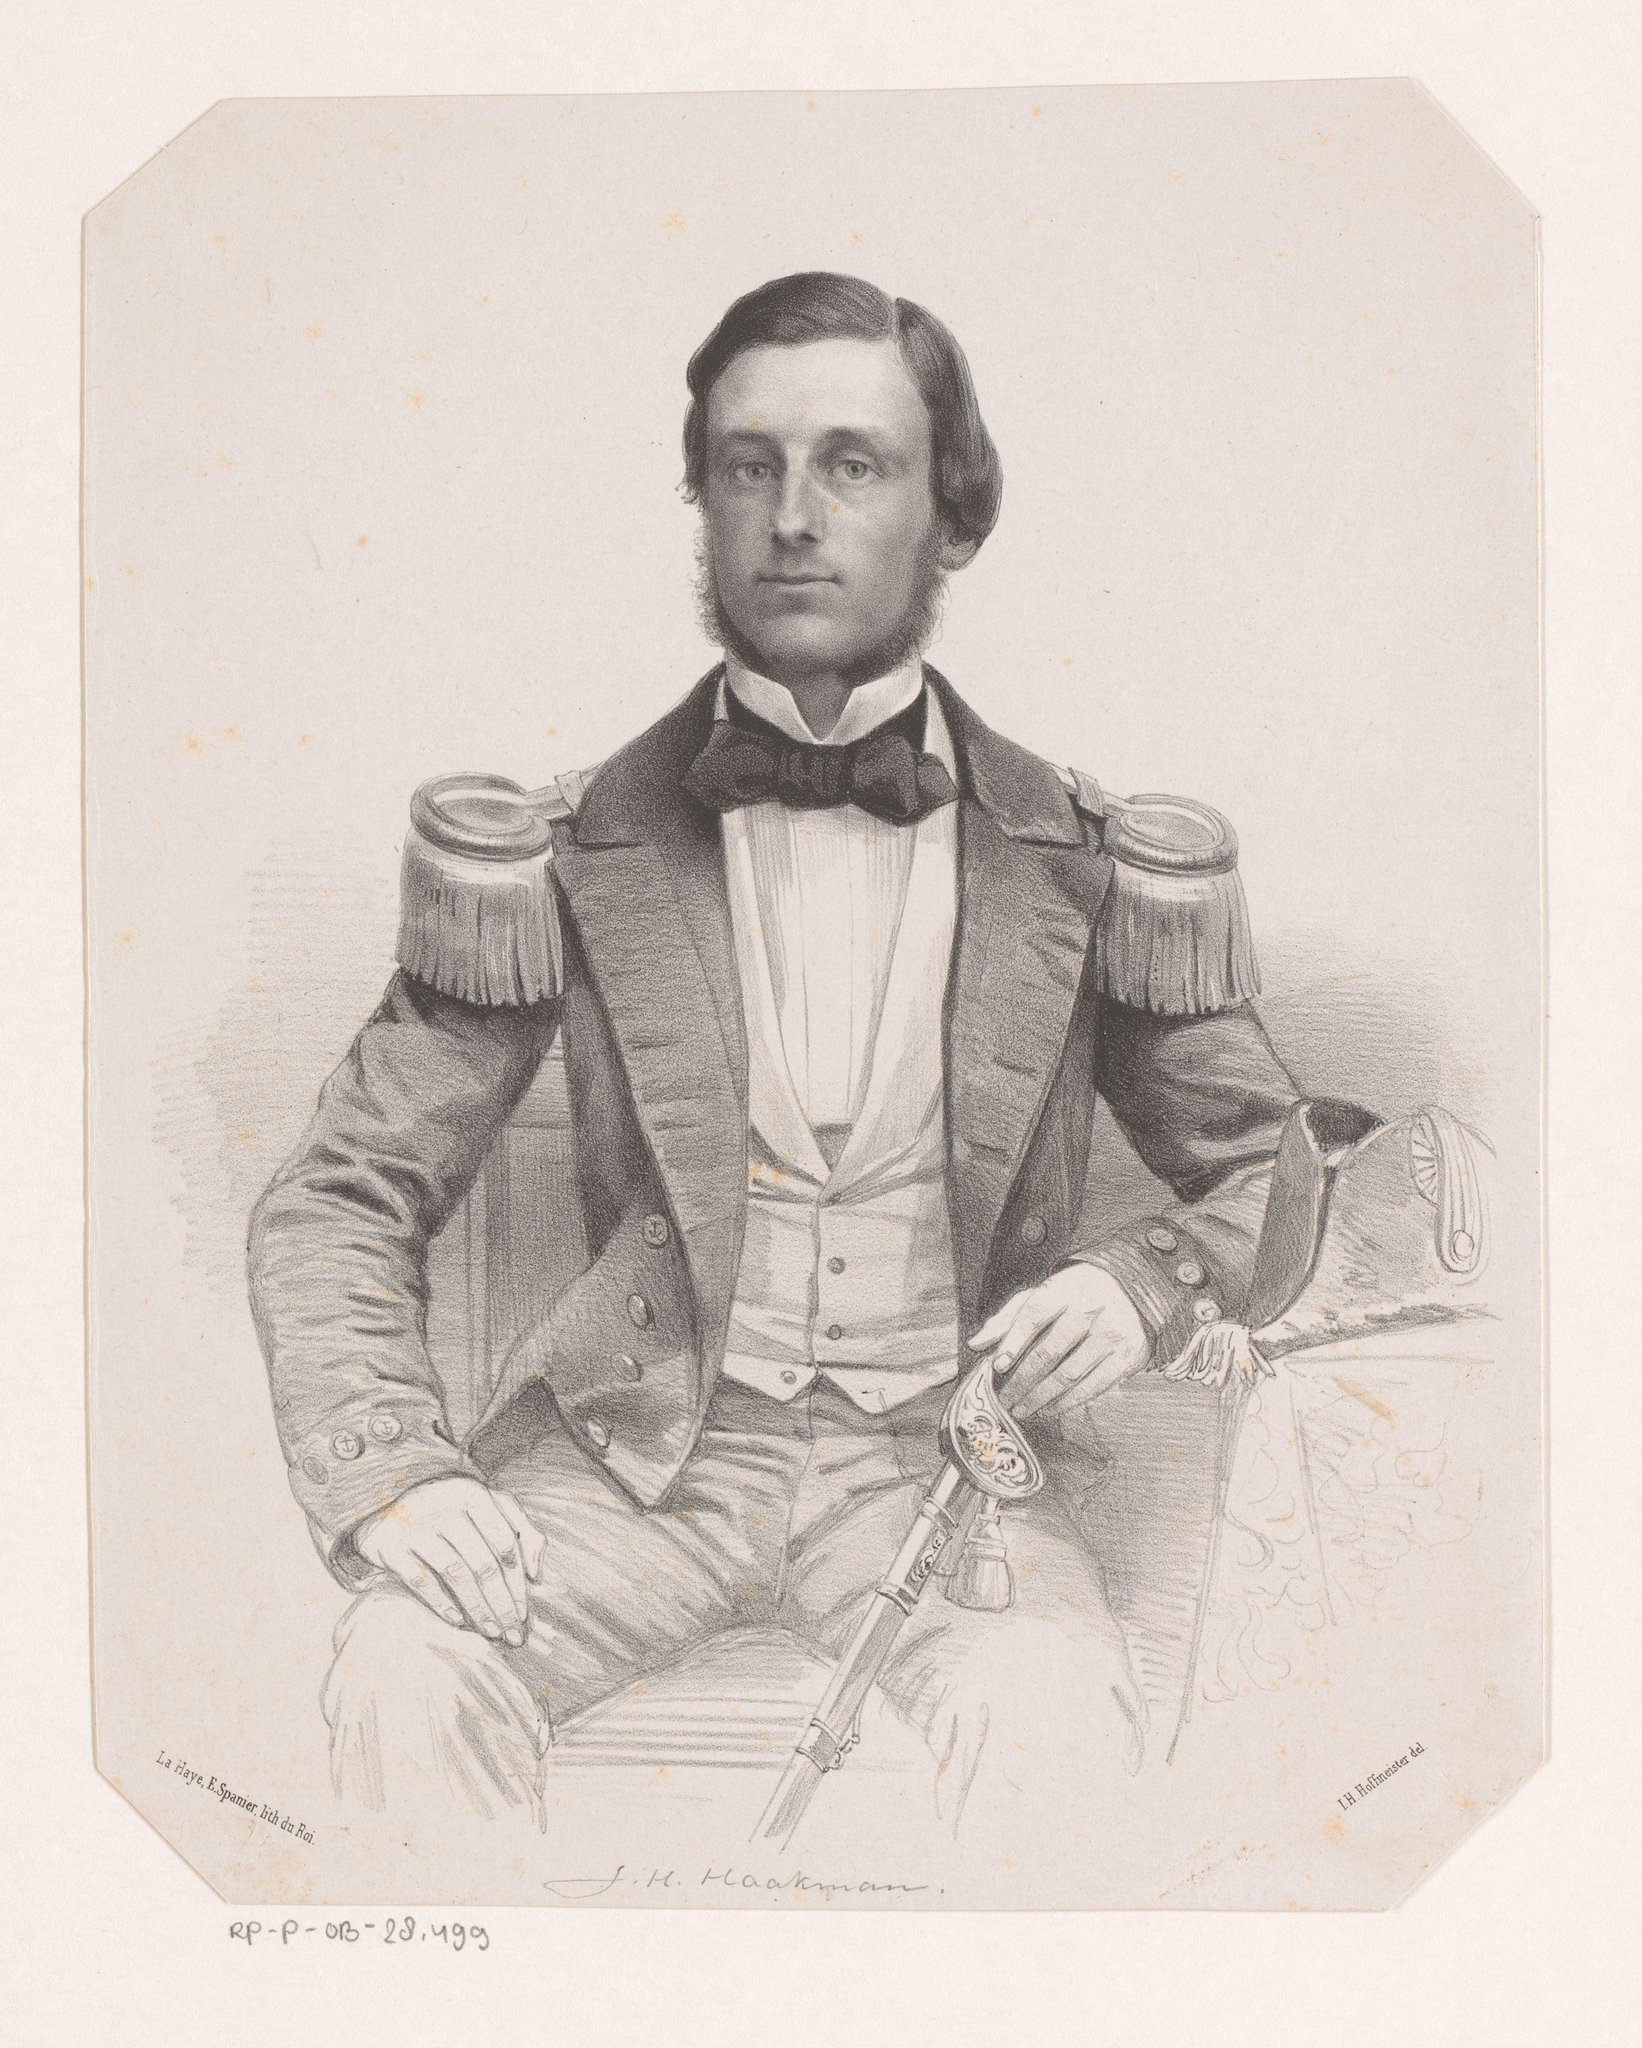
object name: print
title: Portret van J.H. Haakman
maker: johan hendrik hoffmeister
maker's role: print maker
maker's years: 1823-1904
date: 1851-1883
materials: paper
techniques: lithograph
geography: netherlands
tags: hacking and thrusting weapons (with name), historical persons (+ three-quarter length portrait)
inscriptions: collector's mark: Lugt 2228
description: De geportretteerde zit naast een tafel met daarop een steek. Hij heeft een sabel in zijn linkerhand.